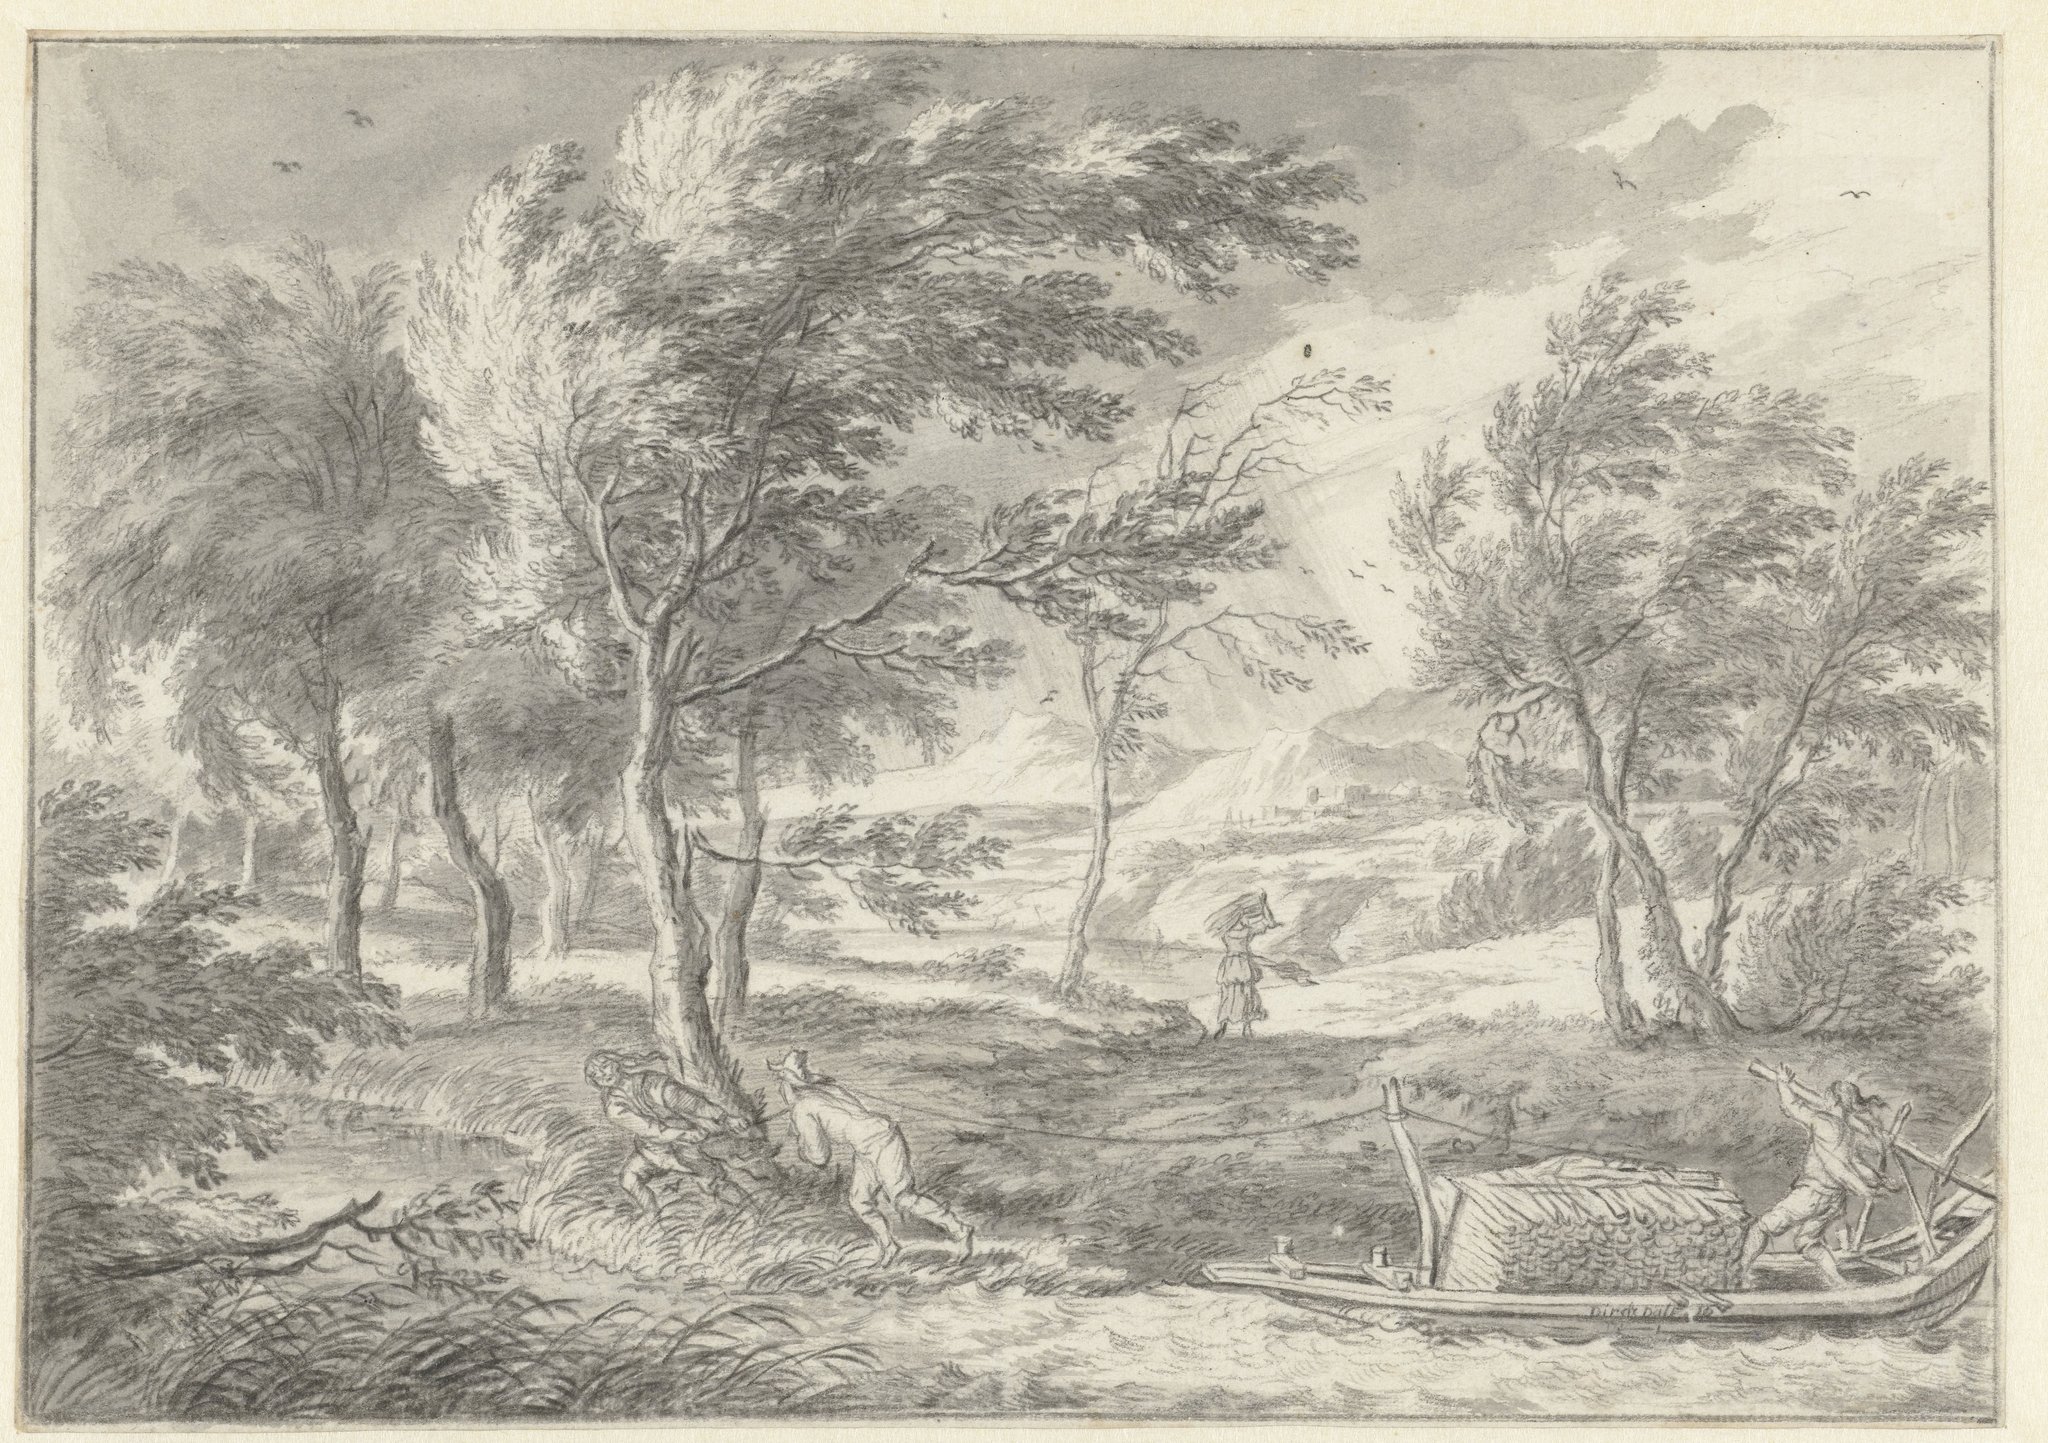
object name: drawing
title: Landschap met naderend onweer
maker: dirck dalens (i)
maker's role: draughtsman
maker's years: 1600-1676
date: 1610-1676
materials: chalk, paper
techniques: brush